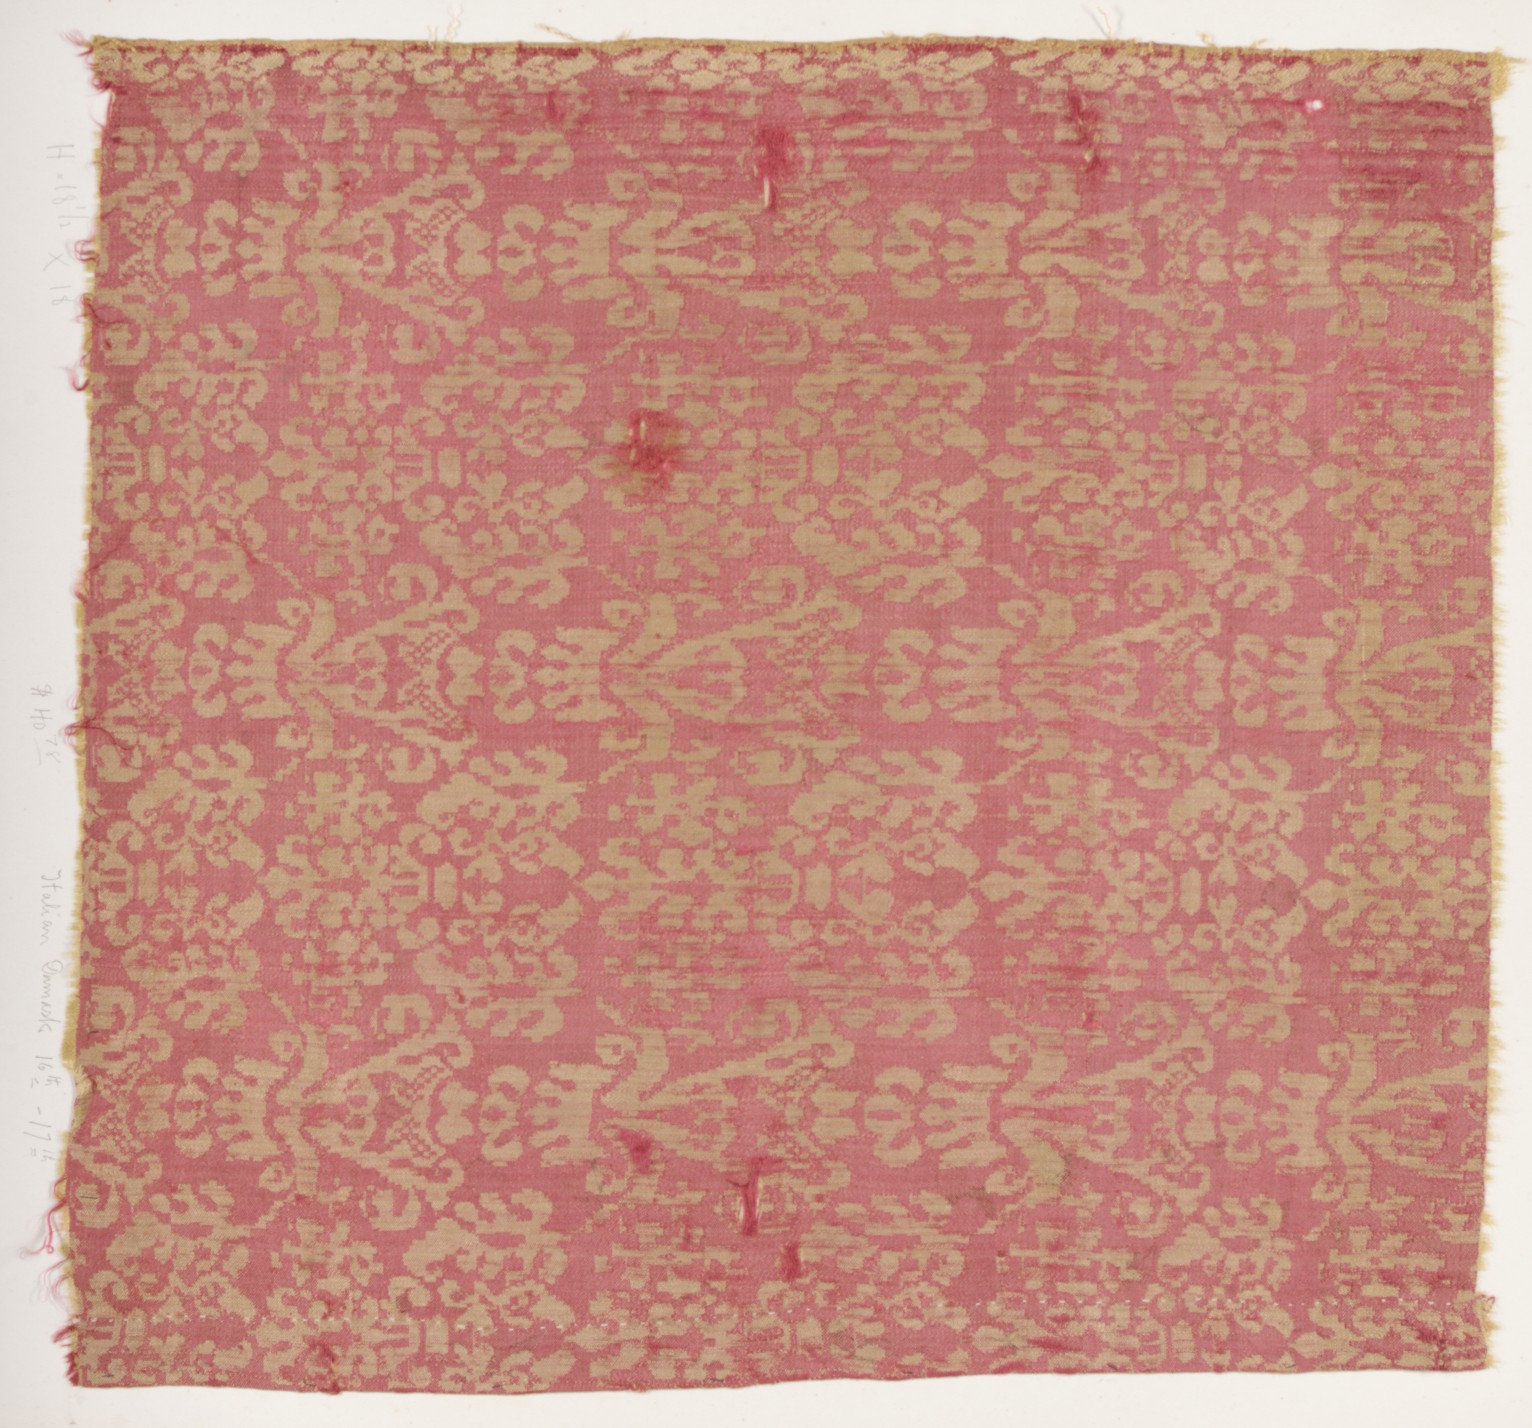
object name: fragment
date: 1501-1700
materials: silk